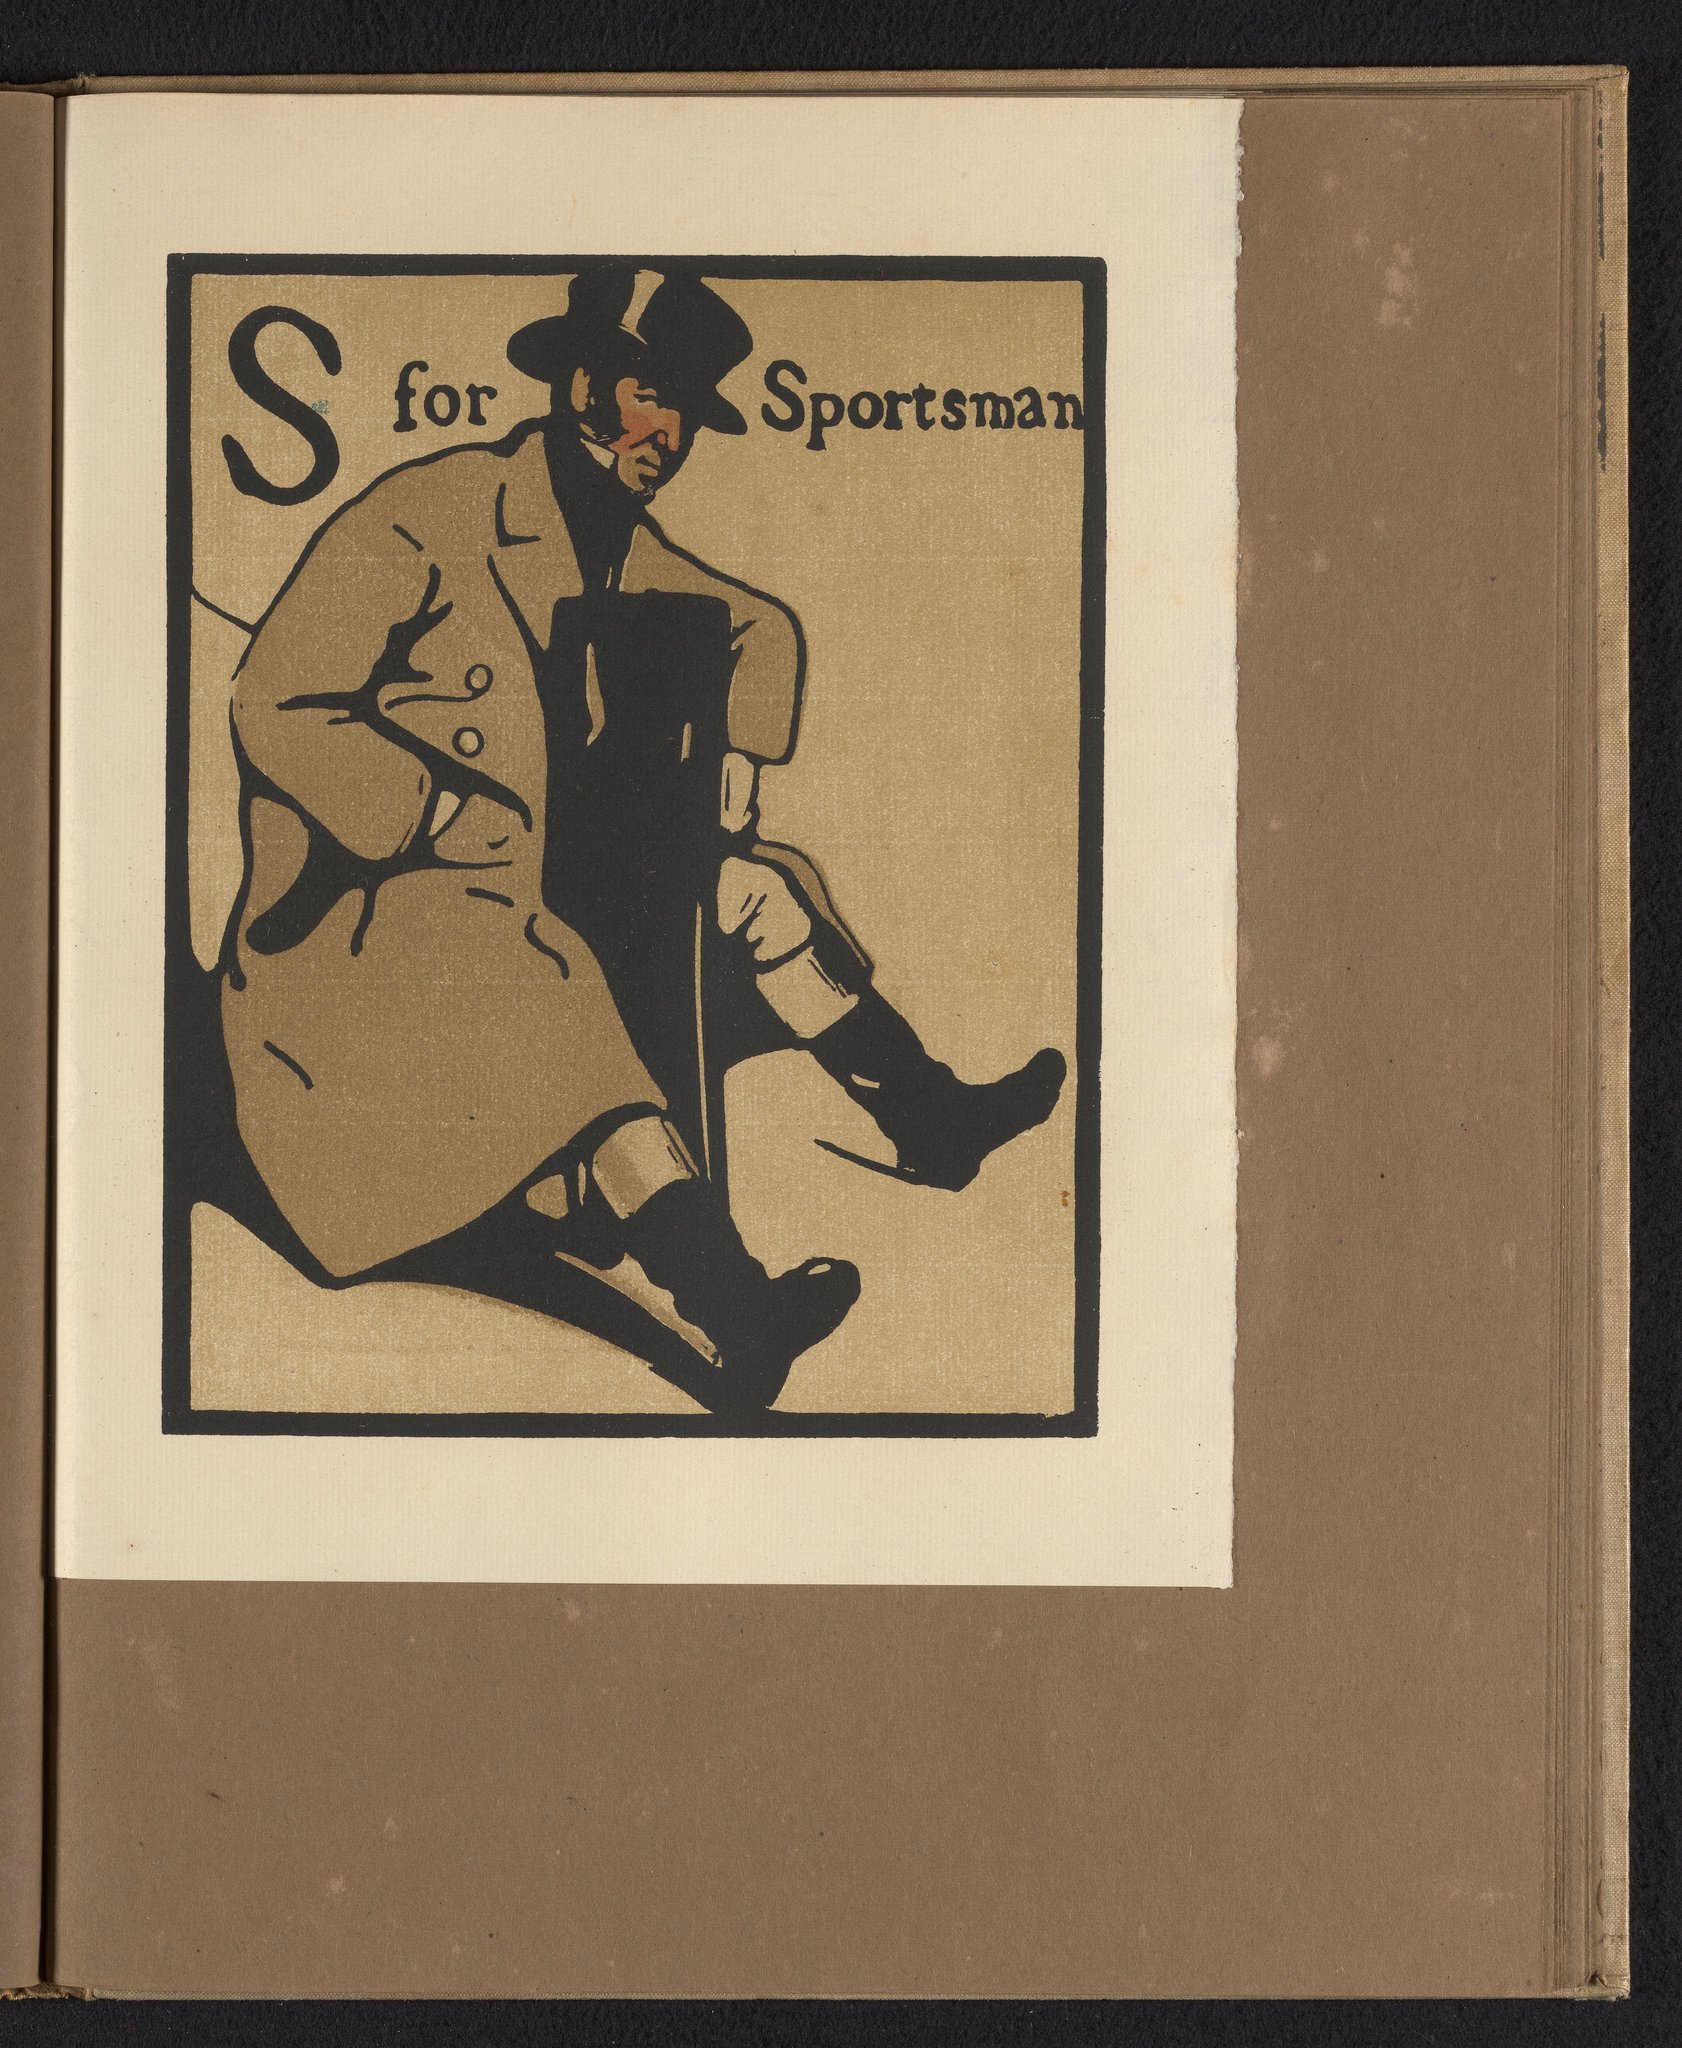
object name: page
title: S for Sportsman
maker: william heinemann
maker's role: publisher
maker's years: 1863-1920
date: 1898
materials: paper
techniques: lithograph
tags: adult man, sports, games ~ animals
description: De serie met lithografieën is gemaakt naar ontwerpen van houtsneden door William Nicholson.